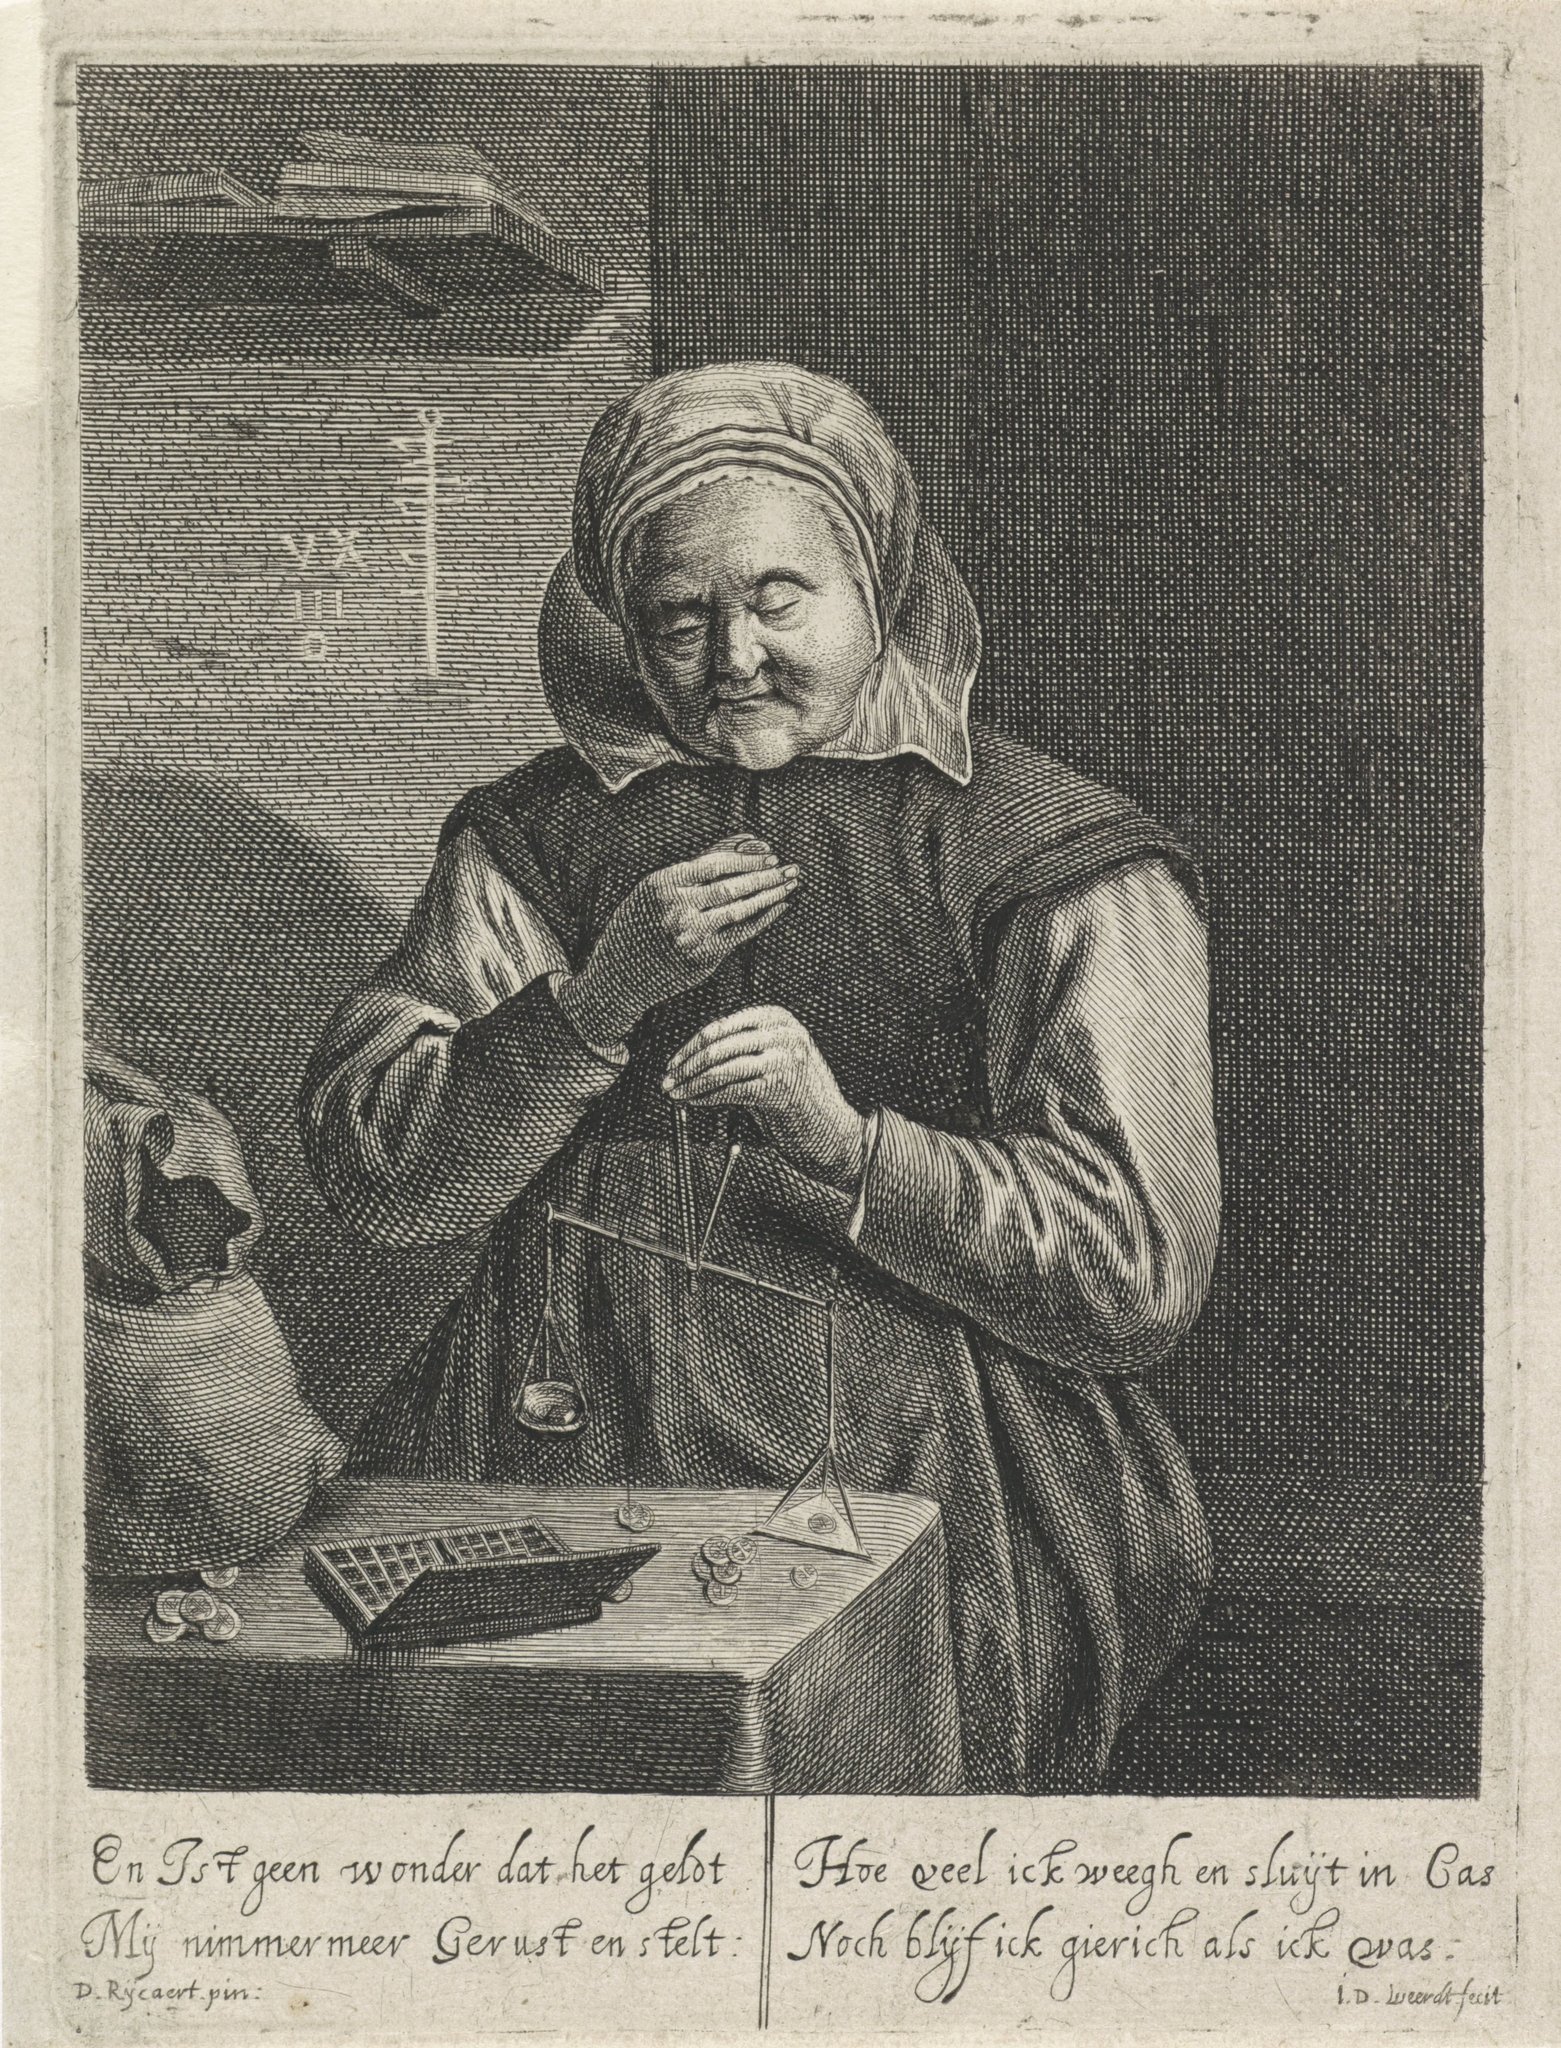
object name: print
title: Zeven zonden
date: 1636-1700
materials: paper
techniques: engraving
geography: antwerp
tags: purse, money-bag, balance, equilibrium, greed, covetousness, cupidity; 'cupidità' (ripa), old woman, coin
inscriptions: collector's mark: Lugt 2228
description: Een oude vrouw houdt een weegschaal vast. Ze kijkt naar de munt in haar rechterhand. Op de tafel voor haar ligt een zak met geld, enkele losse munten en een kistje. Links boven haar liggen enkele boeken op een plank. Onder de voorstelling bevindt zich een vierregelig, Nederlandstalig gedicht.